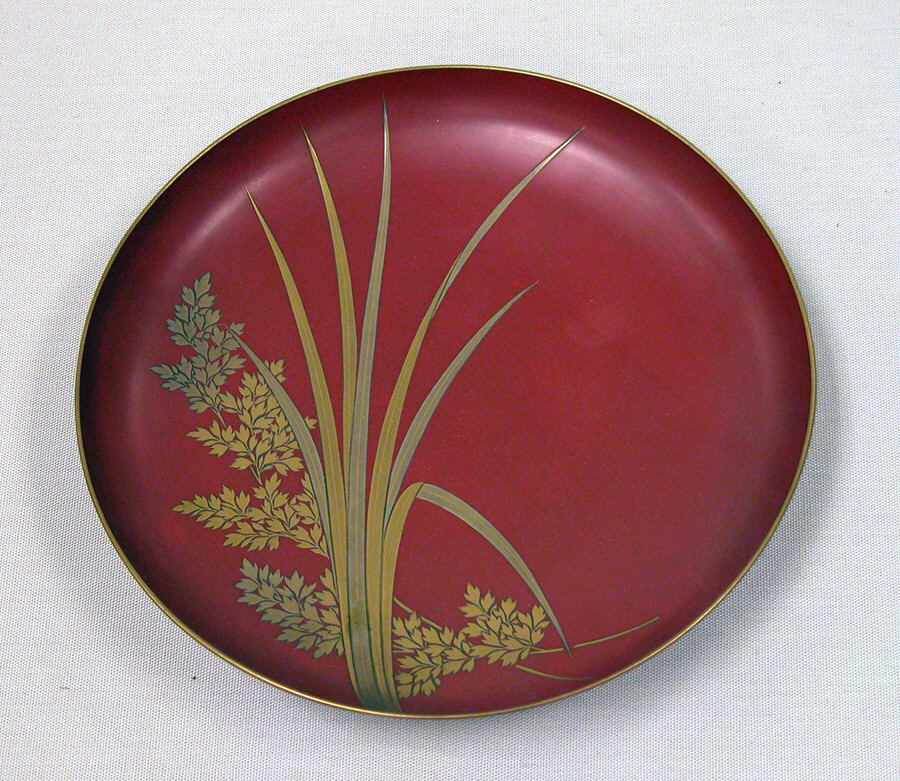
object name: wine cup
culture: japanese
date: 1834-1866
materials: gold, lacquer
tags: leaves